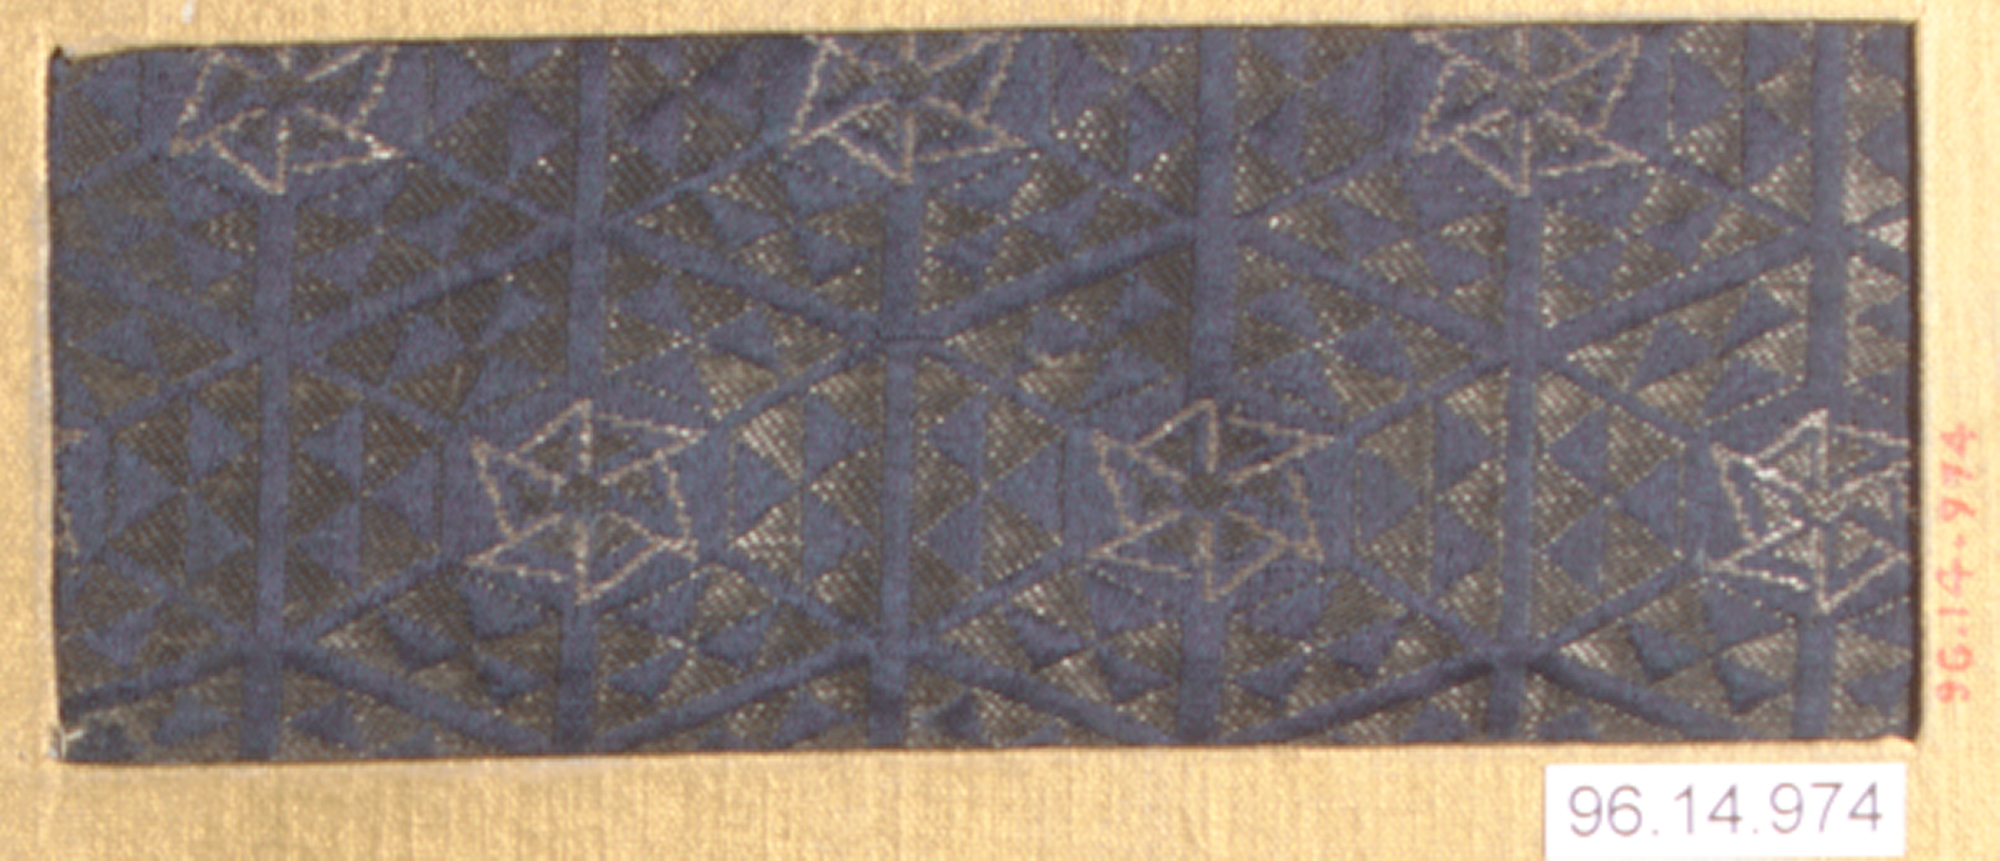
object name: piece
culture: japanese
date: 1701-1900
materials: silk